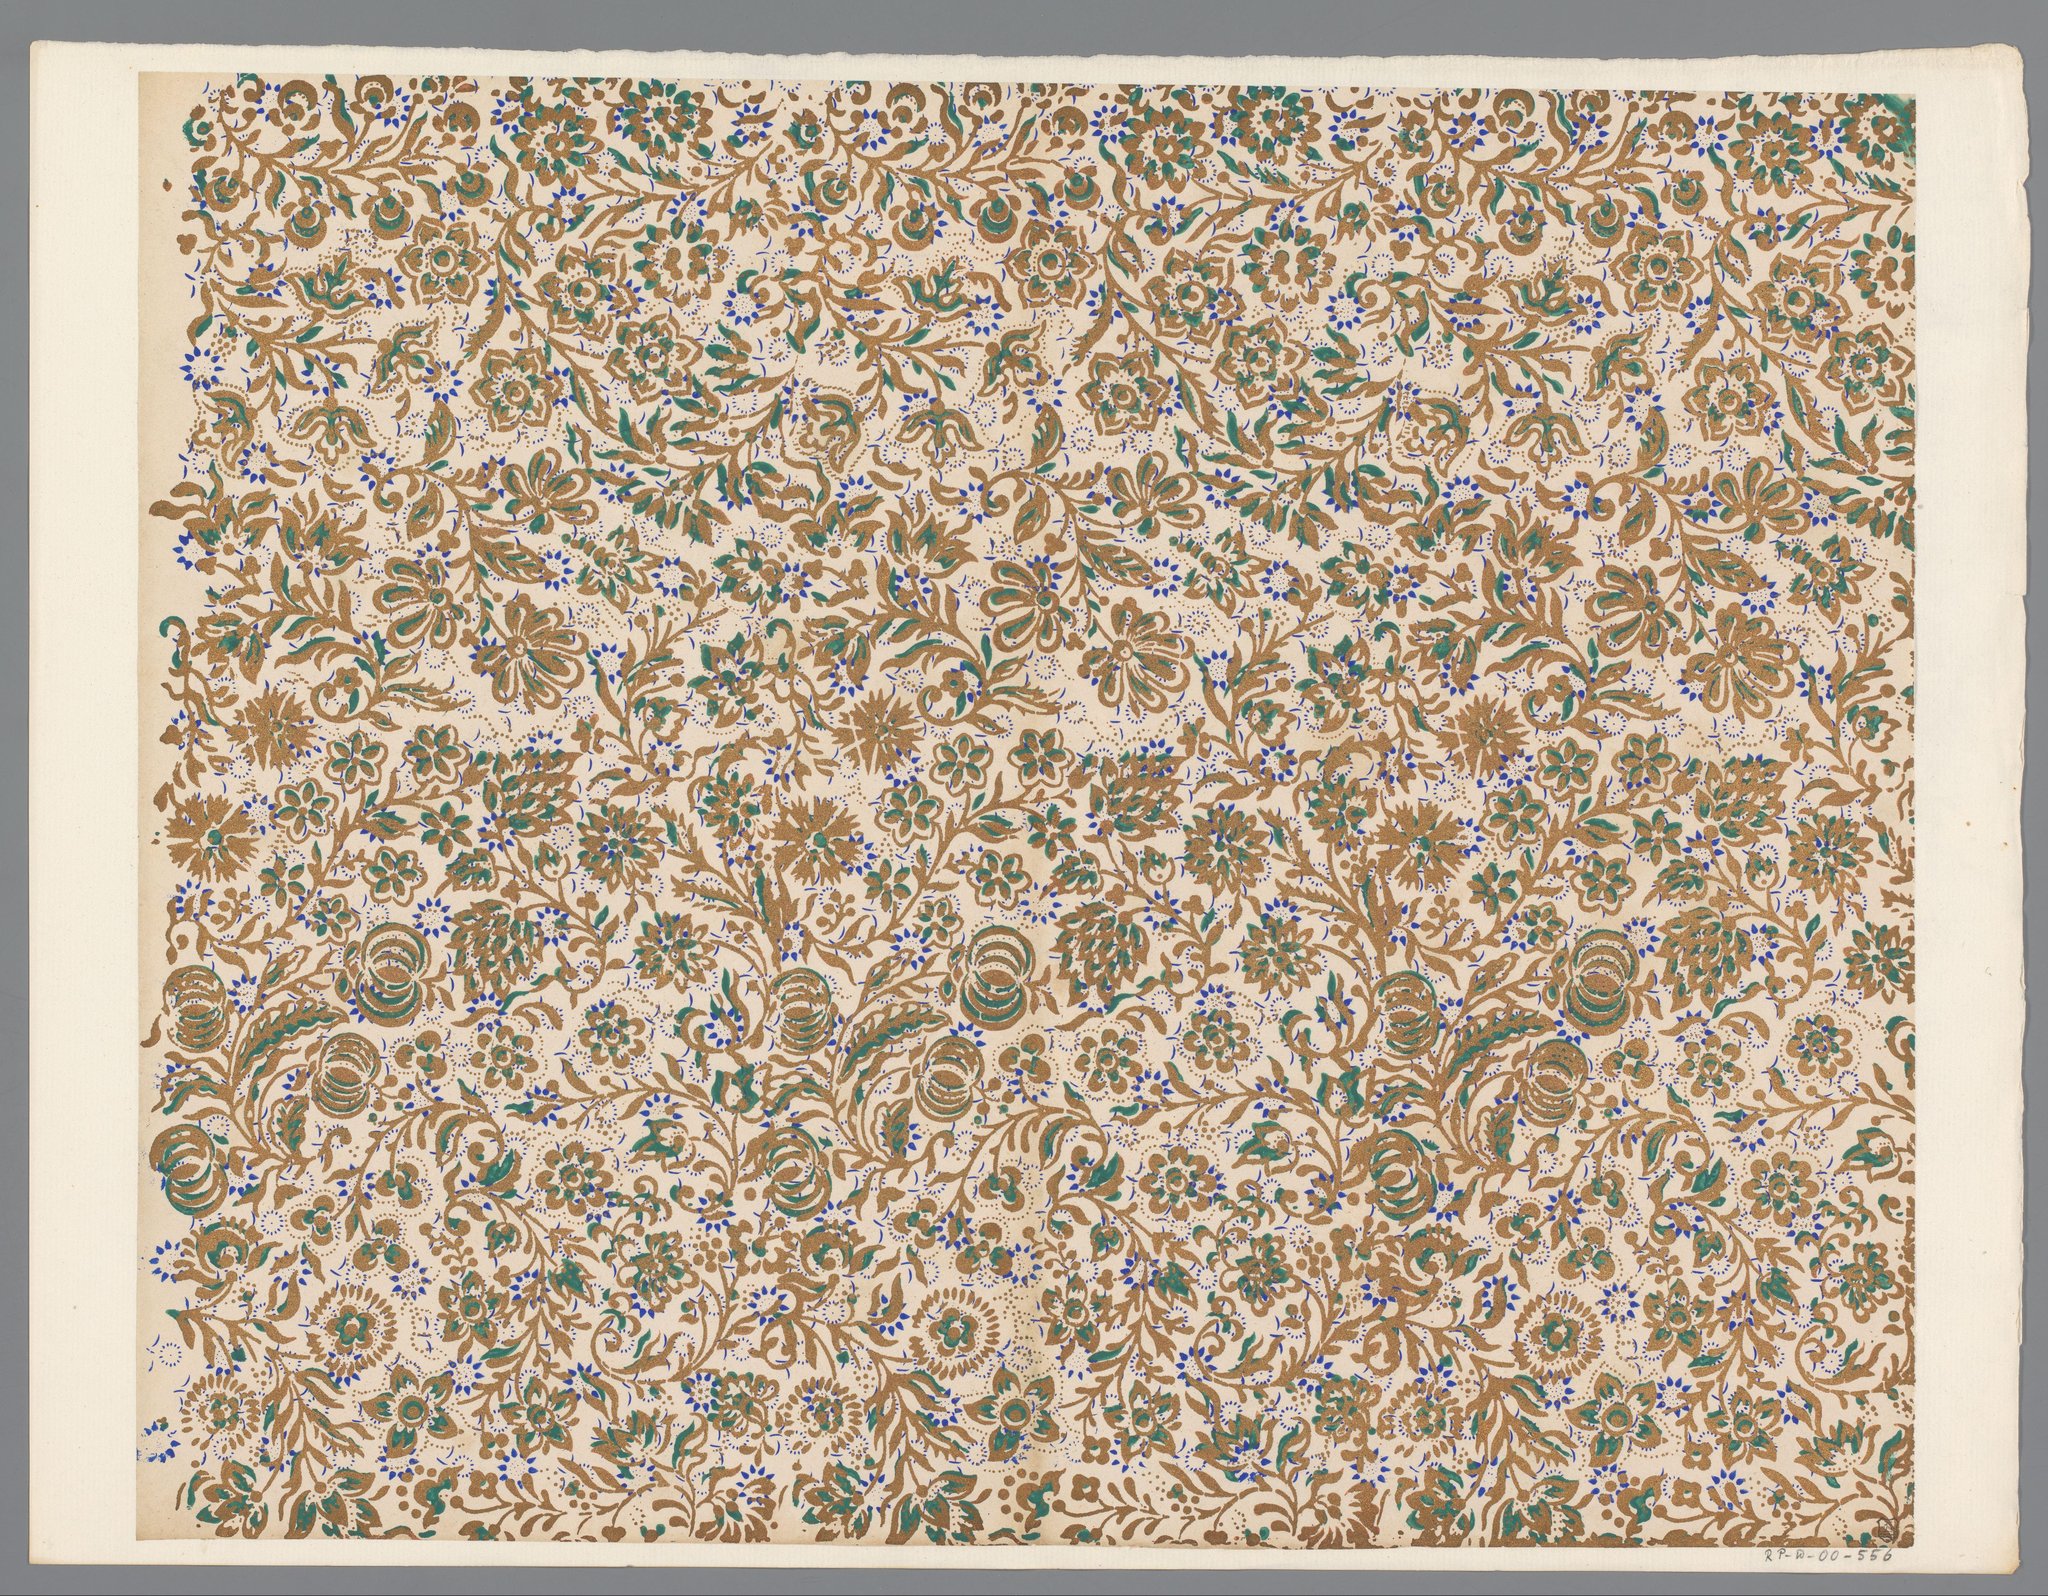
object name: printed paper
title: Blad met strooipatroon van ranken met bloemen en vruchten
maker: Anonymous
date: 1800-1900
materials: paint, paper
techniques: printing block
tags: ornament derived from plant forms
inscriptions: collector's mark: Lugt 2760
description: Blad met strooipatroon van ranken met bloemen en vruchten, en stippellijnen.